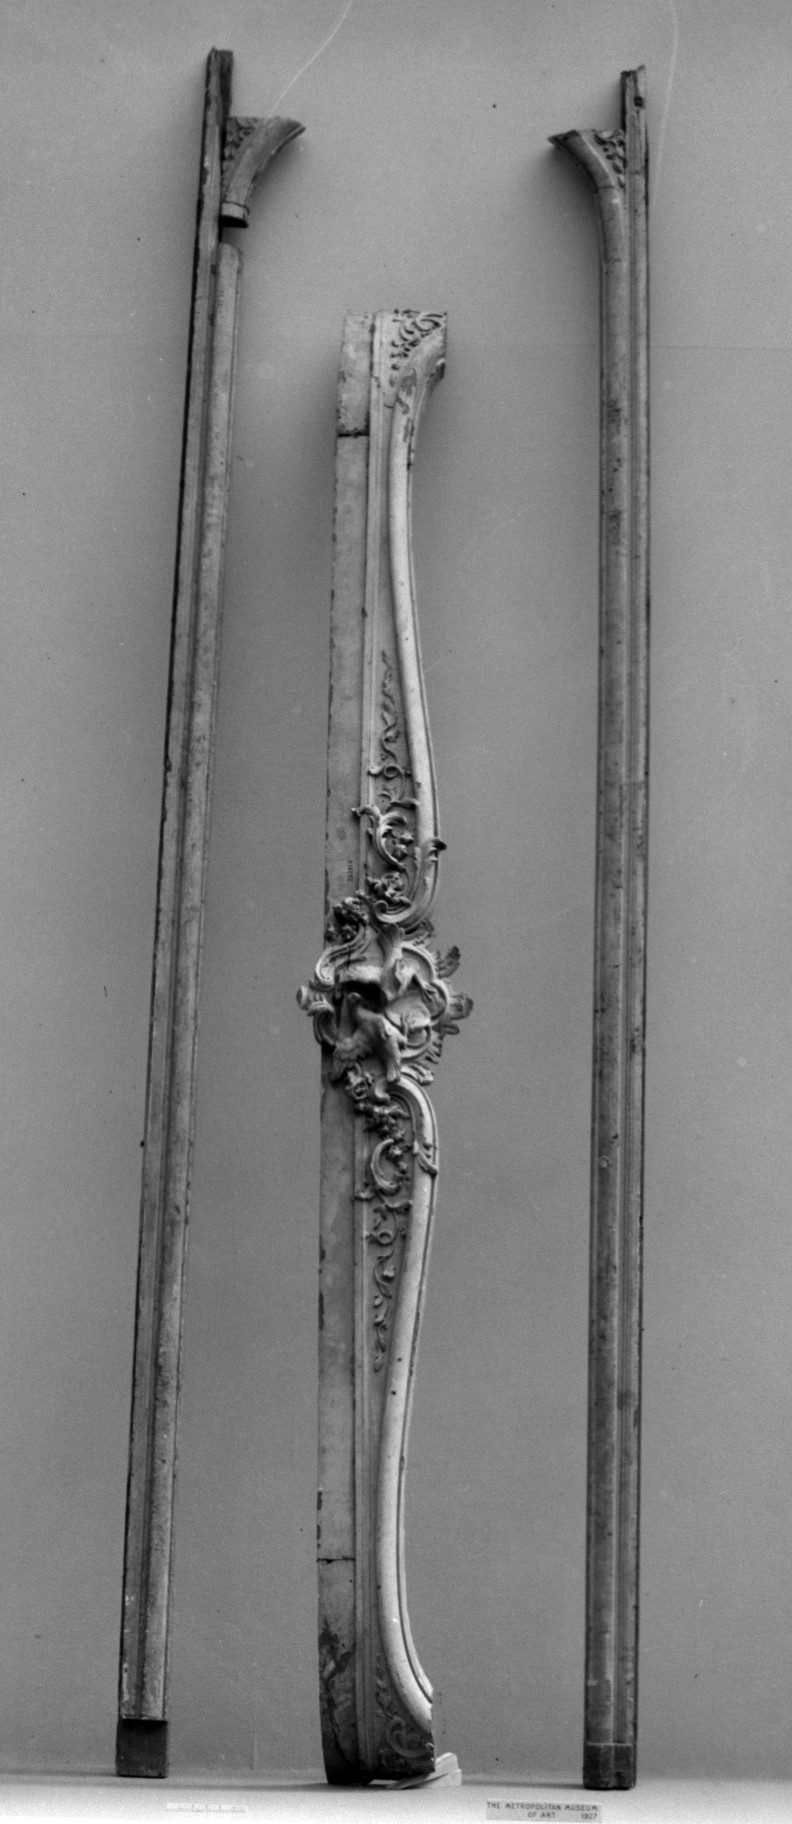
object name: alcove enframement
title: Enframement for alcove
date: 1715-1723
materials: wood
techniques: carving